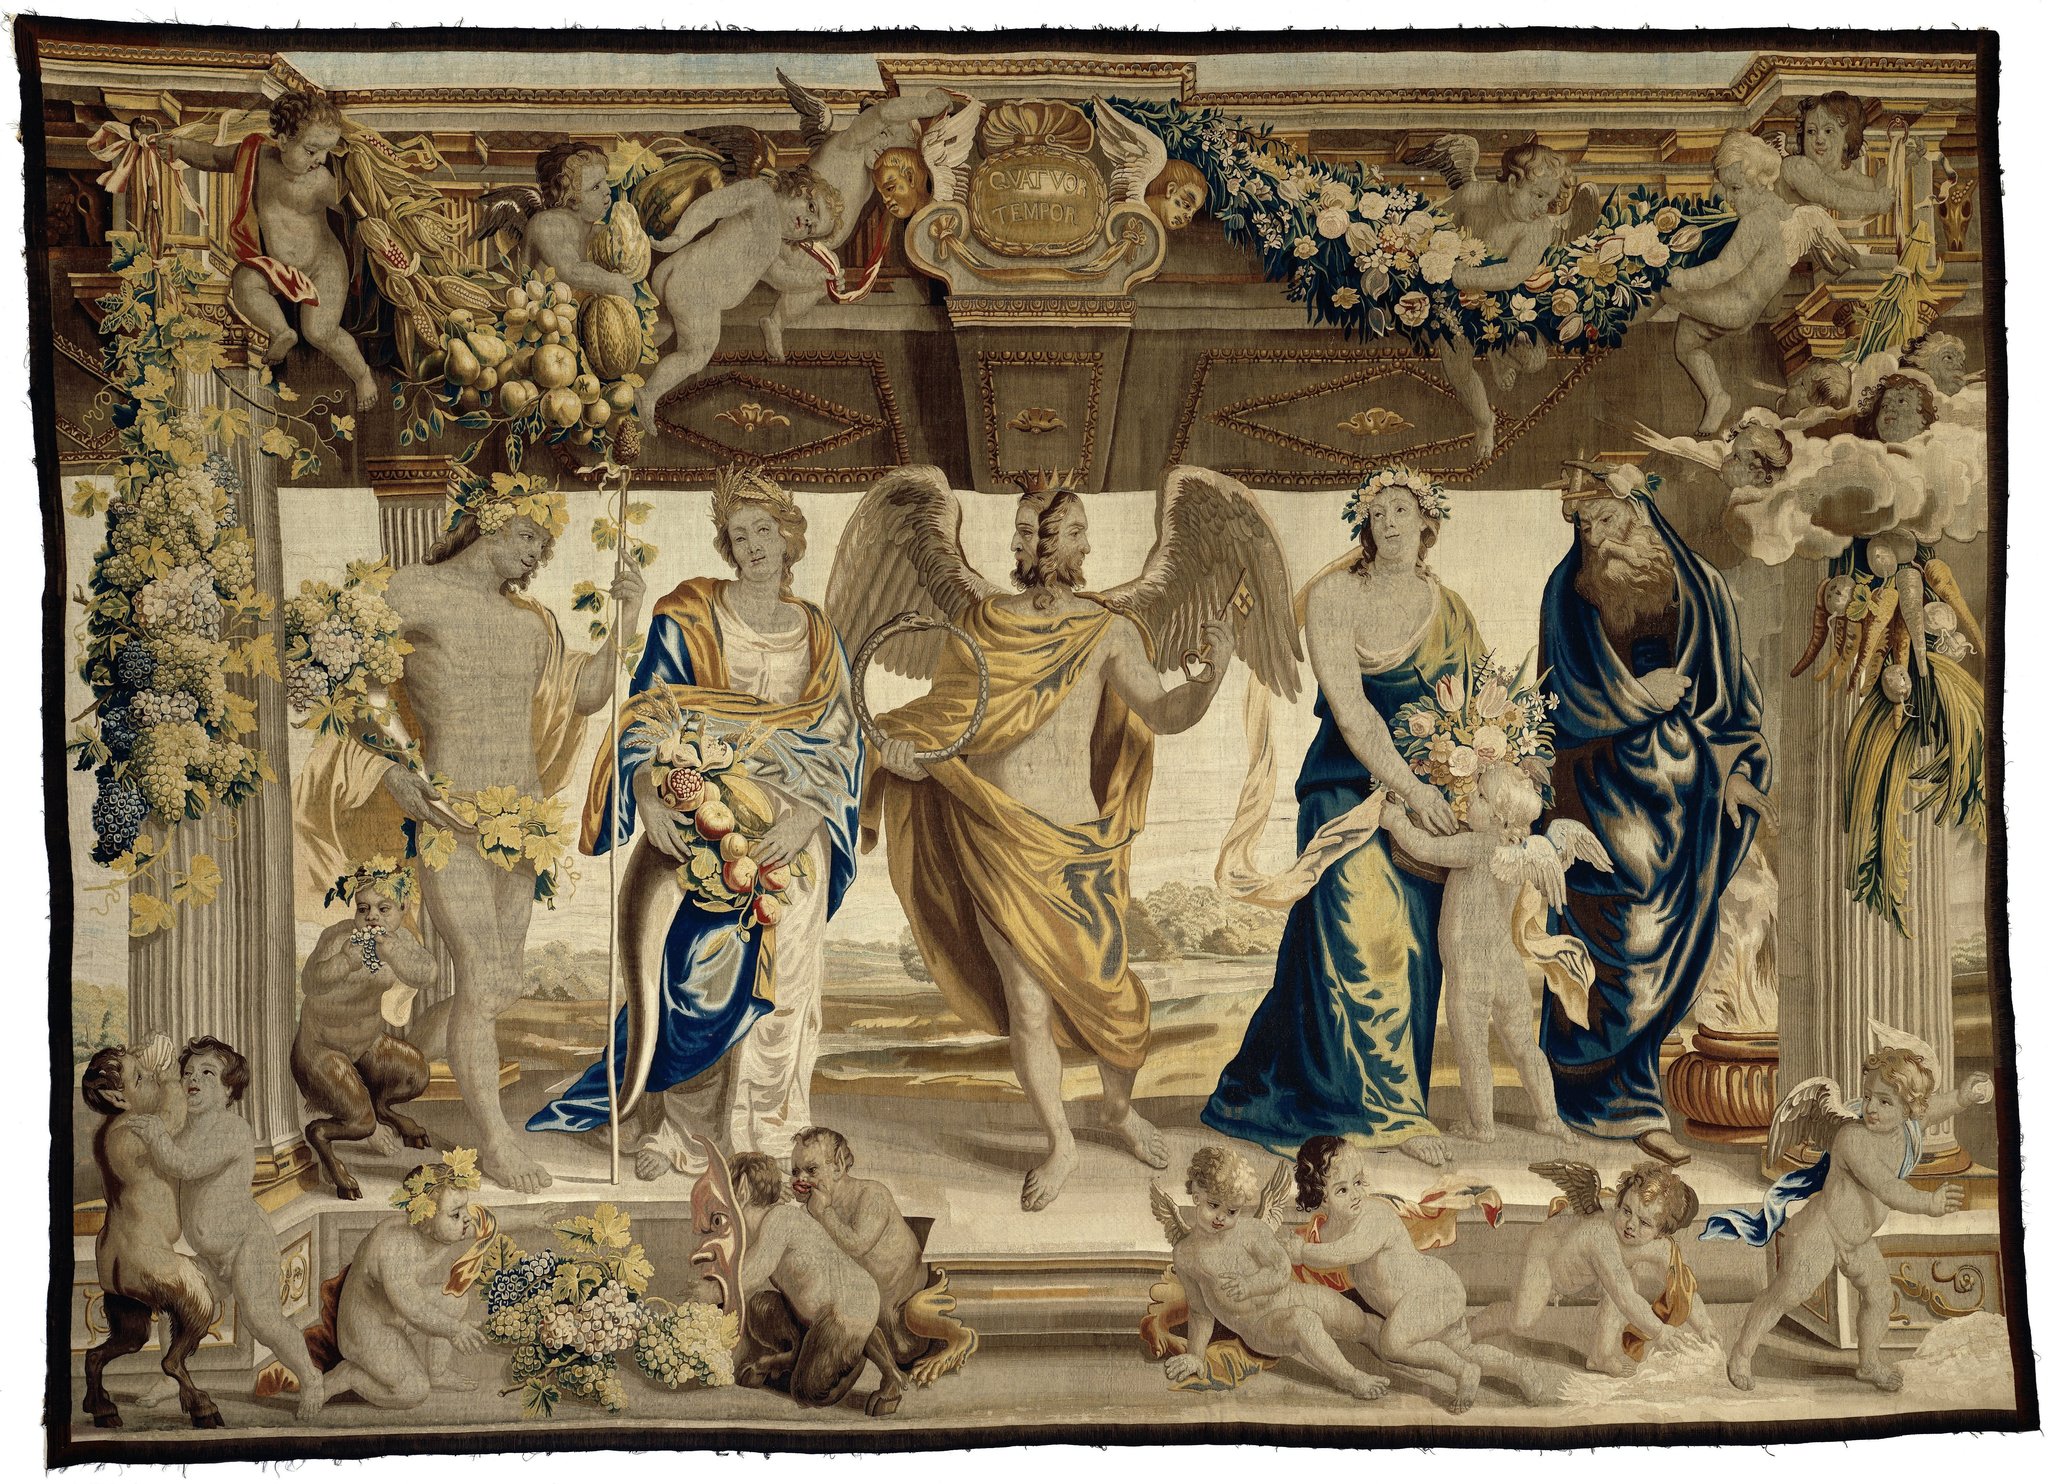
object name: tapestry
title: De vier jaargetijden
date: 1650-1680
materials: metal thread, silk, wool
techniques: tapestry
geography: antwerp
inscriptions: inscription: ‘QVATVOR // TEMPOR’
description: Wandtapijt met een allegorische voorstelling van de vier jaargetijden met Janus uit een serie van tien met de maanden, jaargetijden en elementen, binnen een architecturale omlijsting.